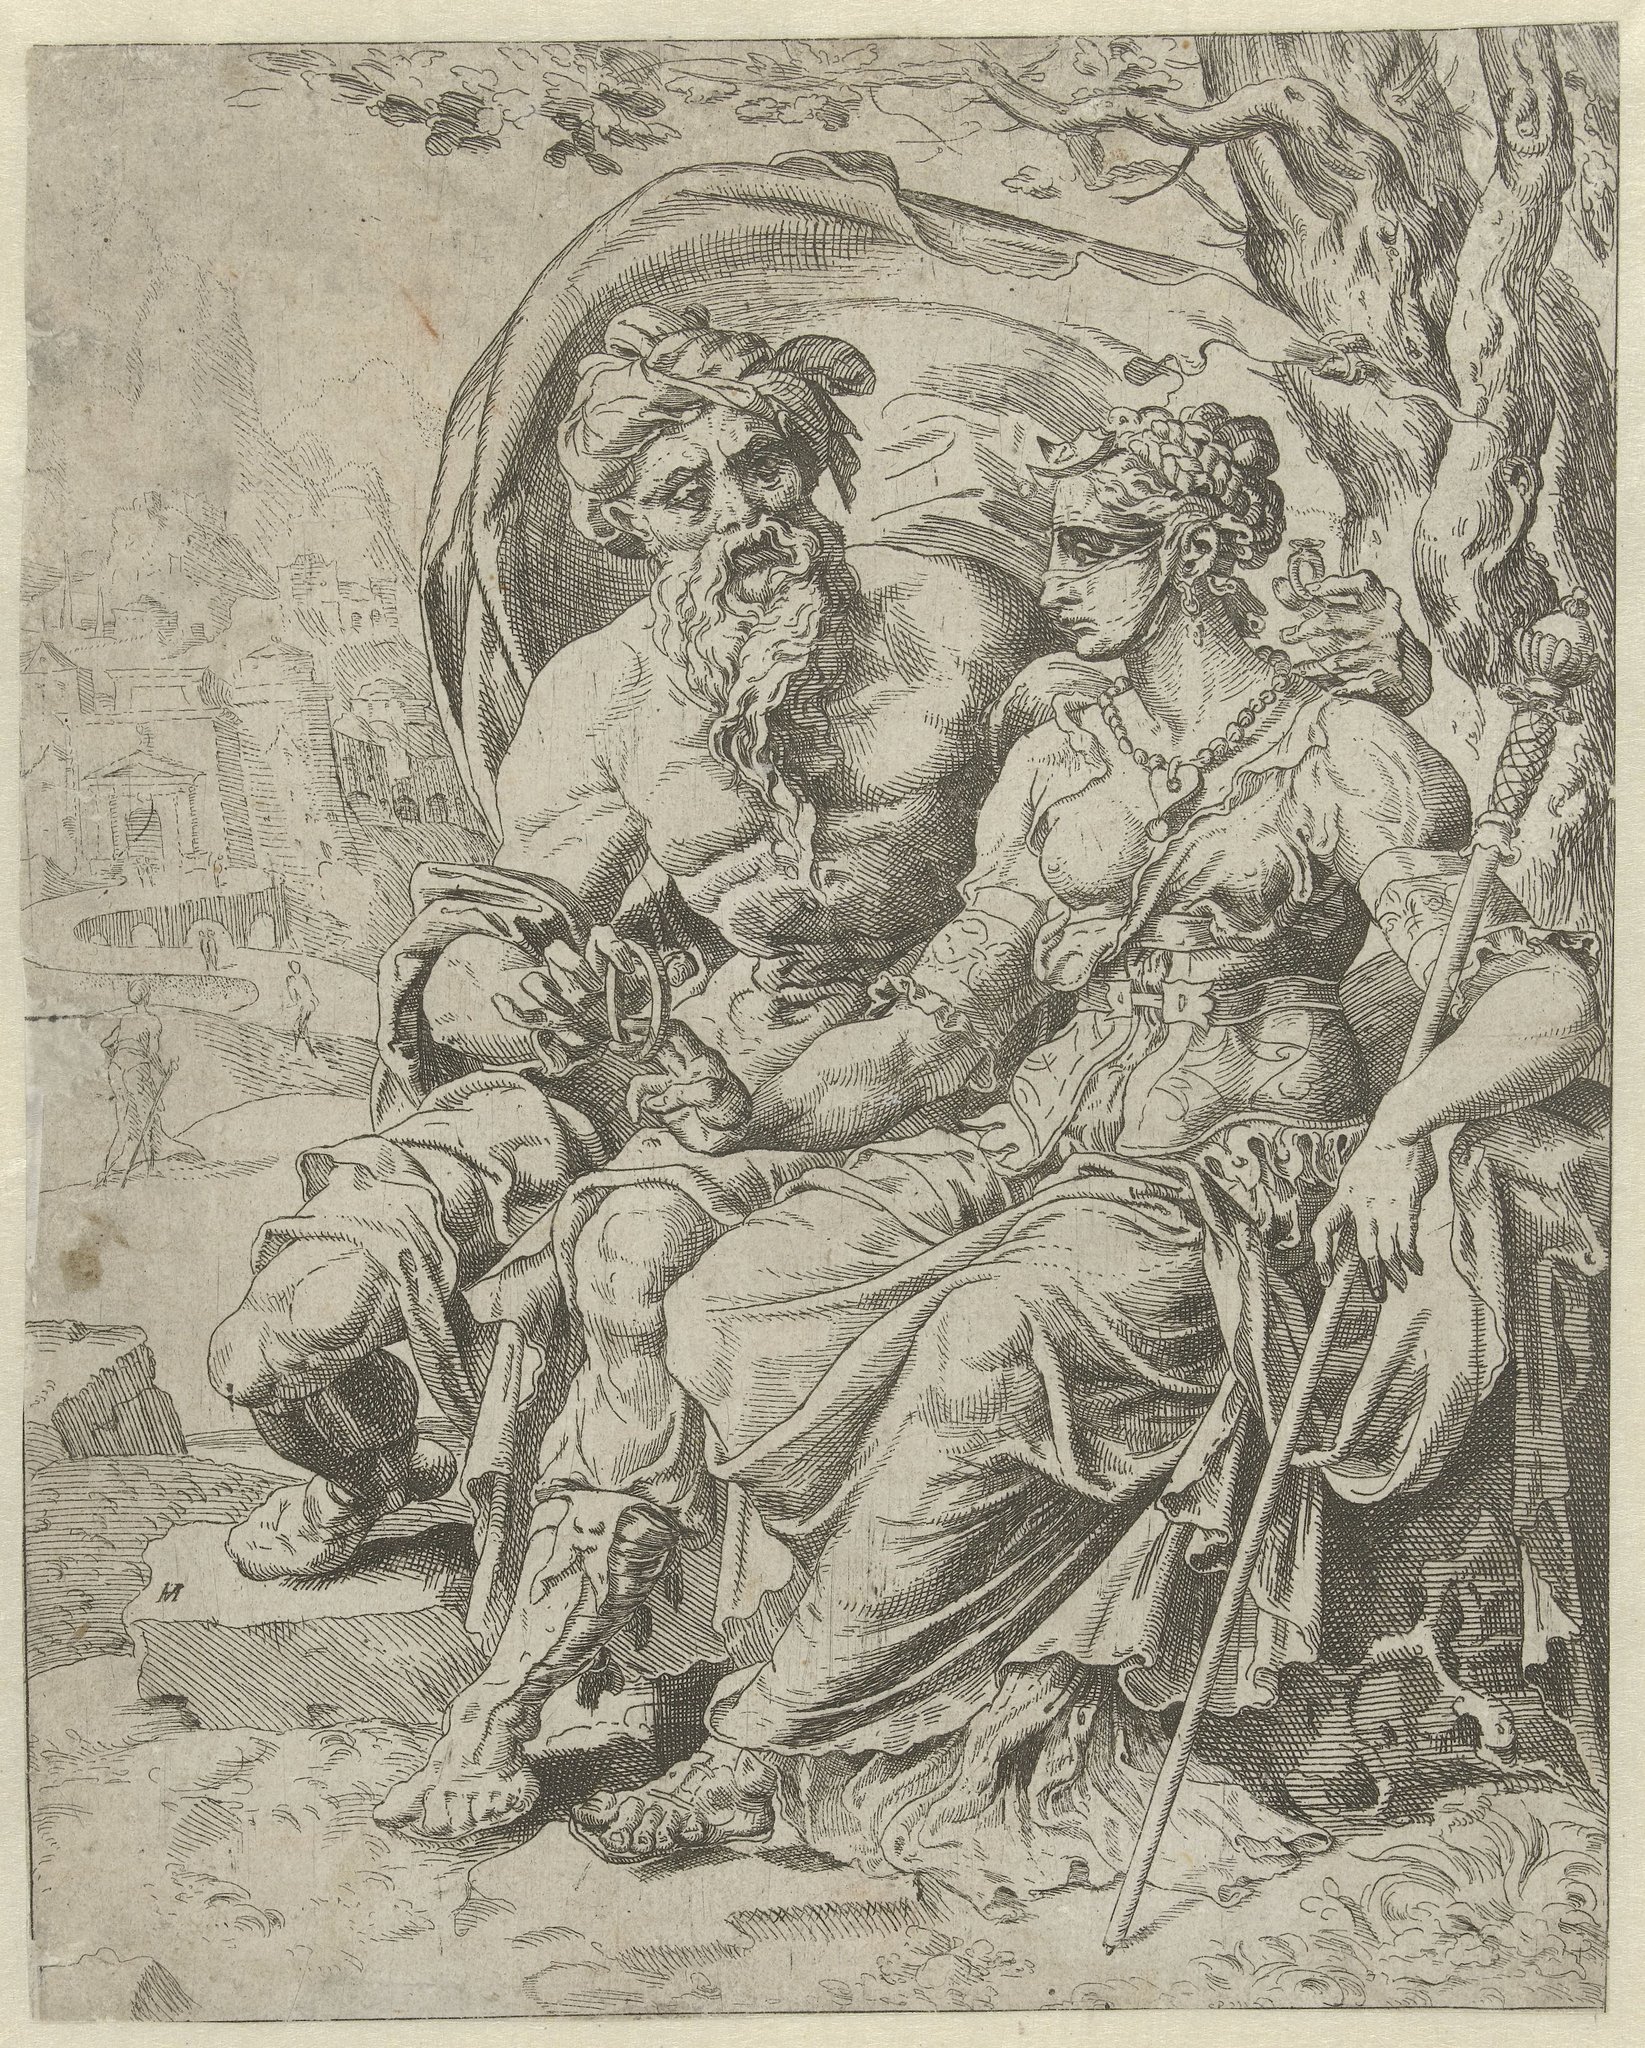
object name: print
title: Juda geeft Tamar het onderpand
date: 1549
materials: paper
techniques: etching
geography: haarlem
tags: judah's love-affair with tamar; he gives her his signet(-ring), bracelets and staff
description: In ruil voor haar diensten als prostituee geeft Juda de vermomde Tamar zijn staf, armband en ring. De prent maakt deel uit van een serie over de geschiedenis van Juda en Tamar